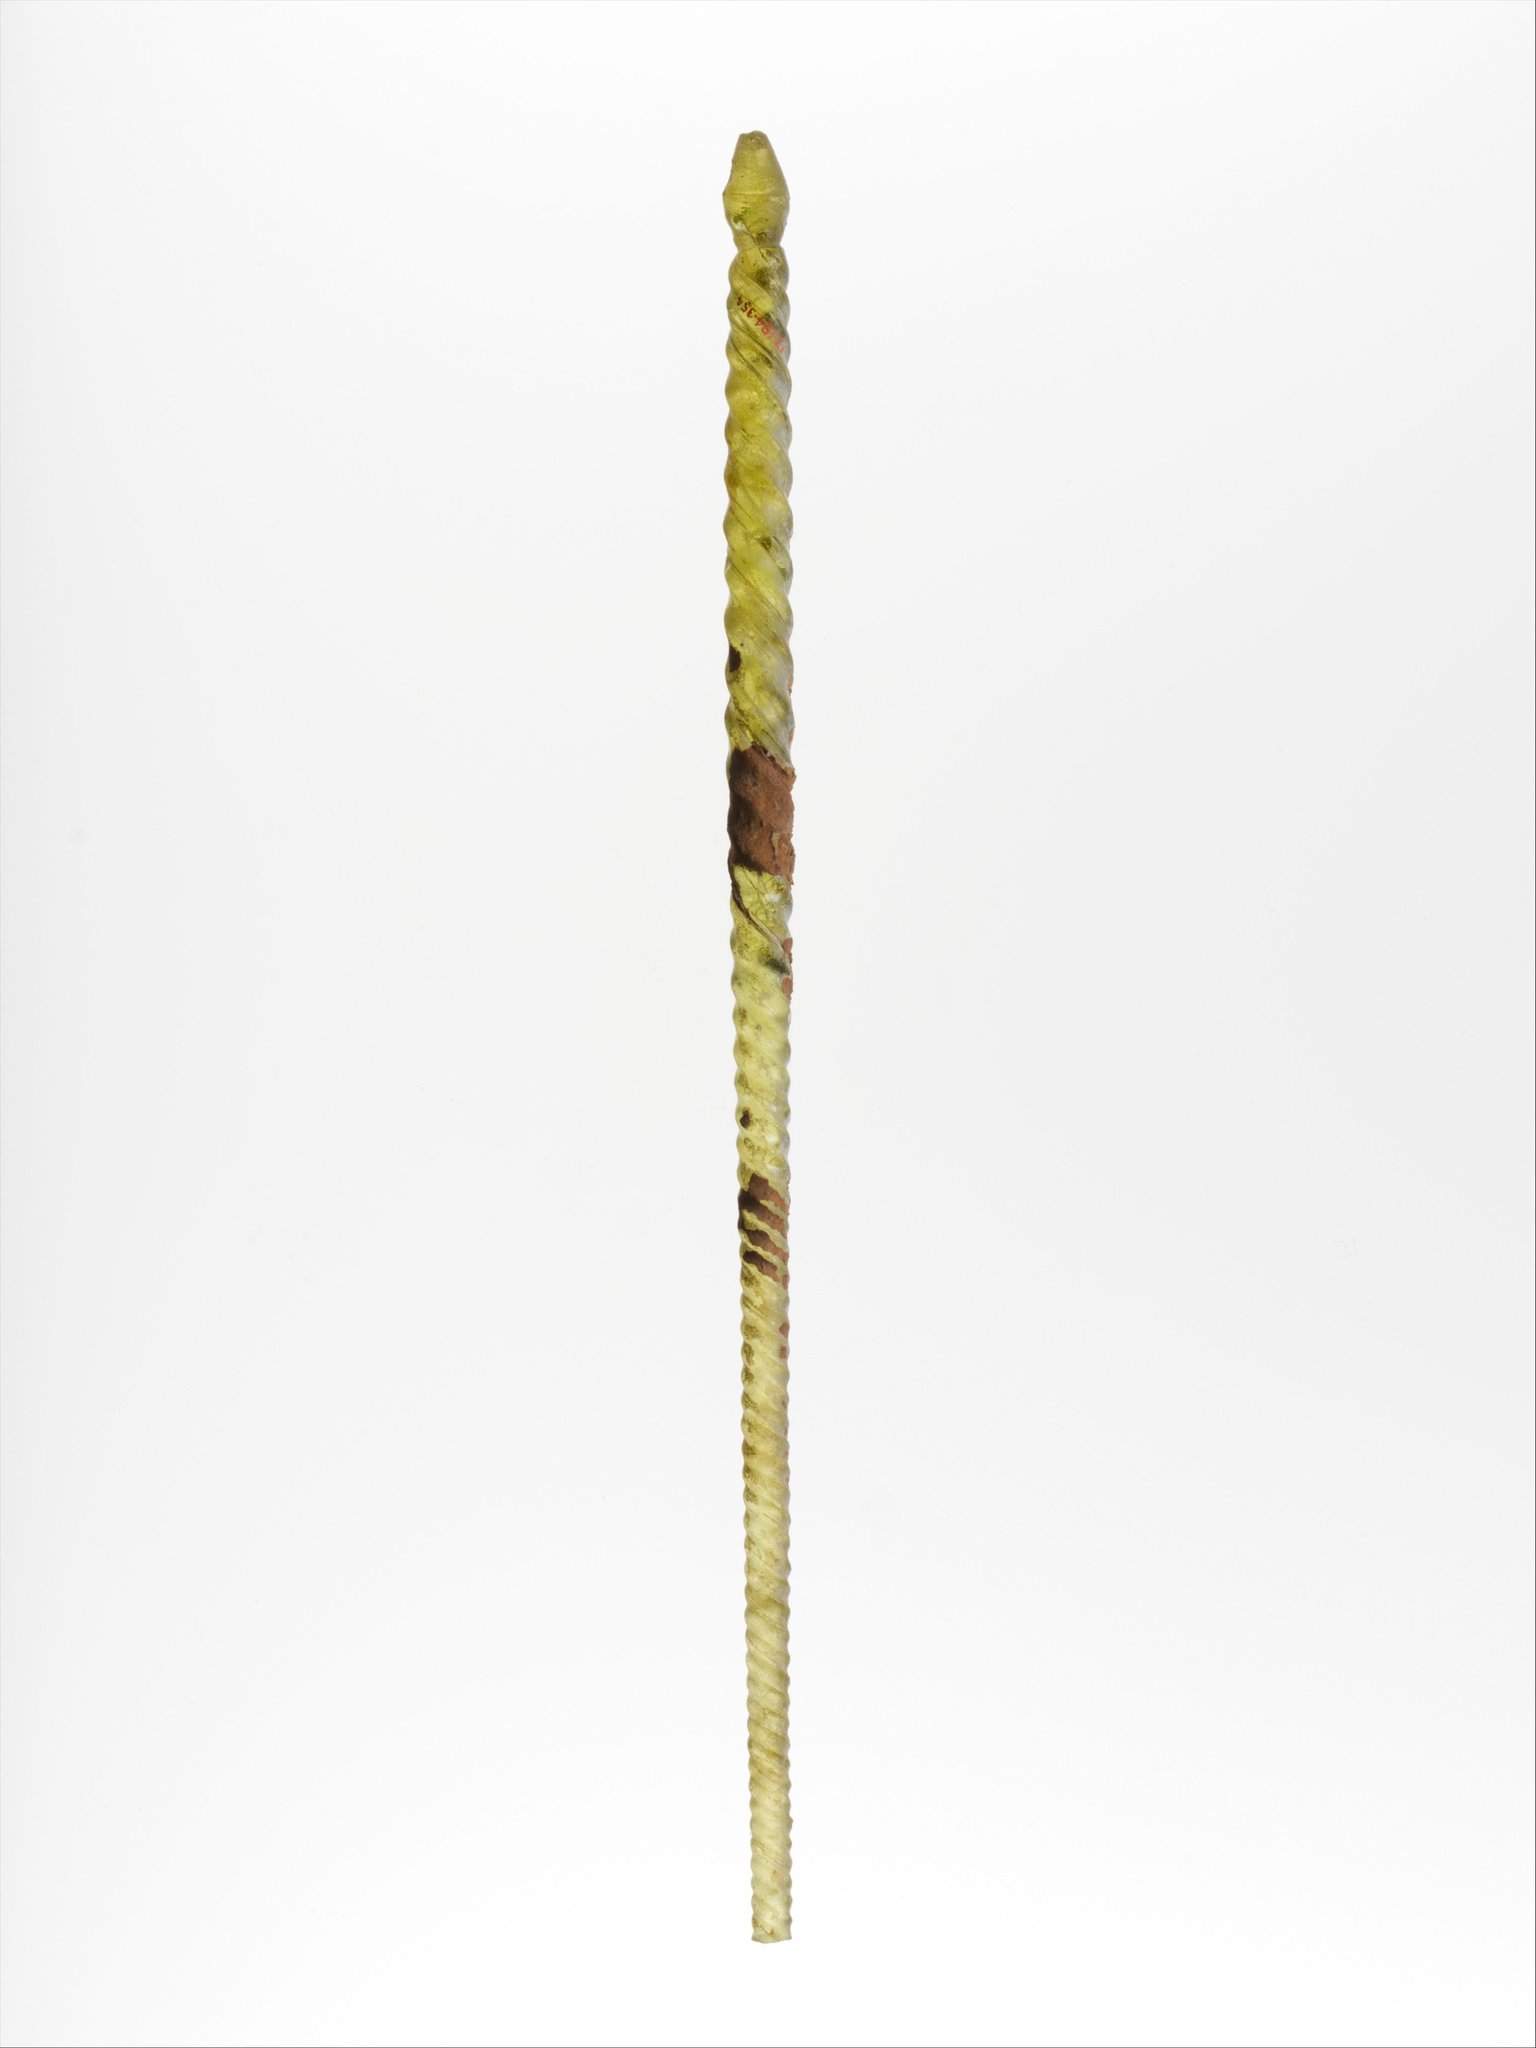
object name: rod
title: Glass rod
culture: roman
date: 1-100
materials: glass